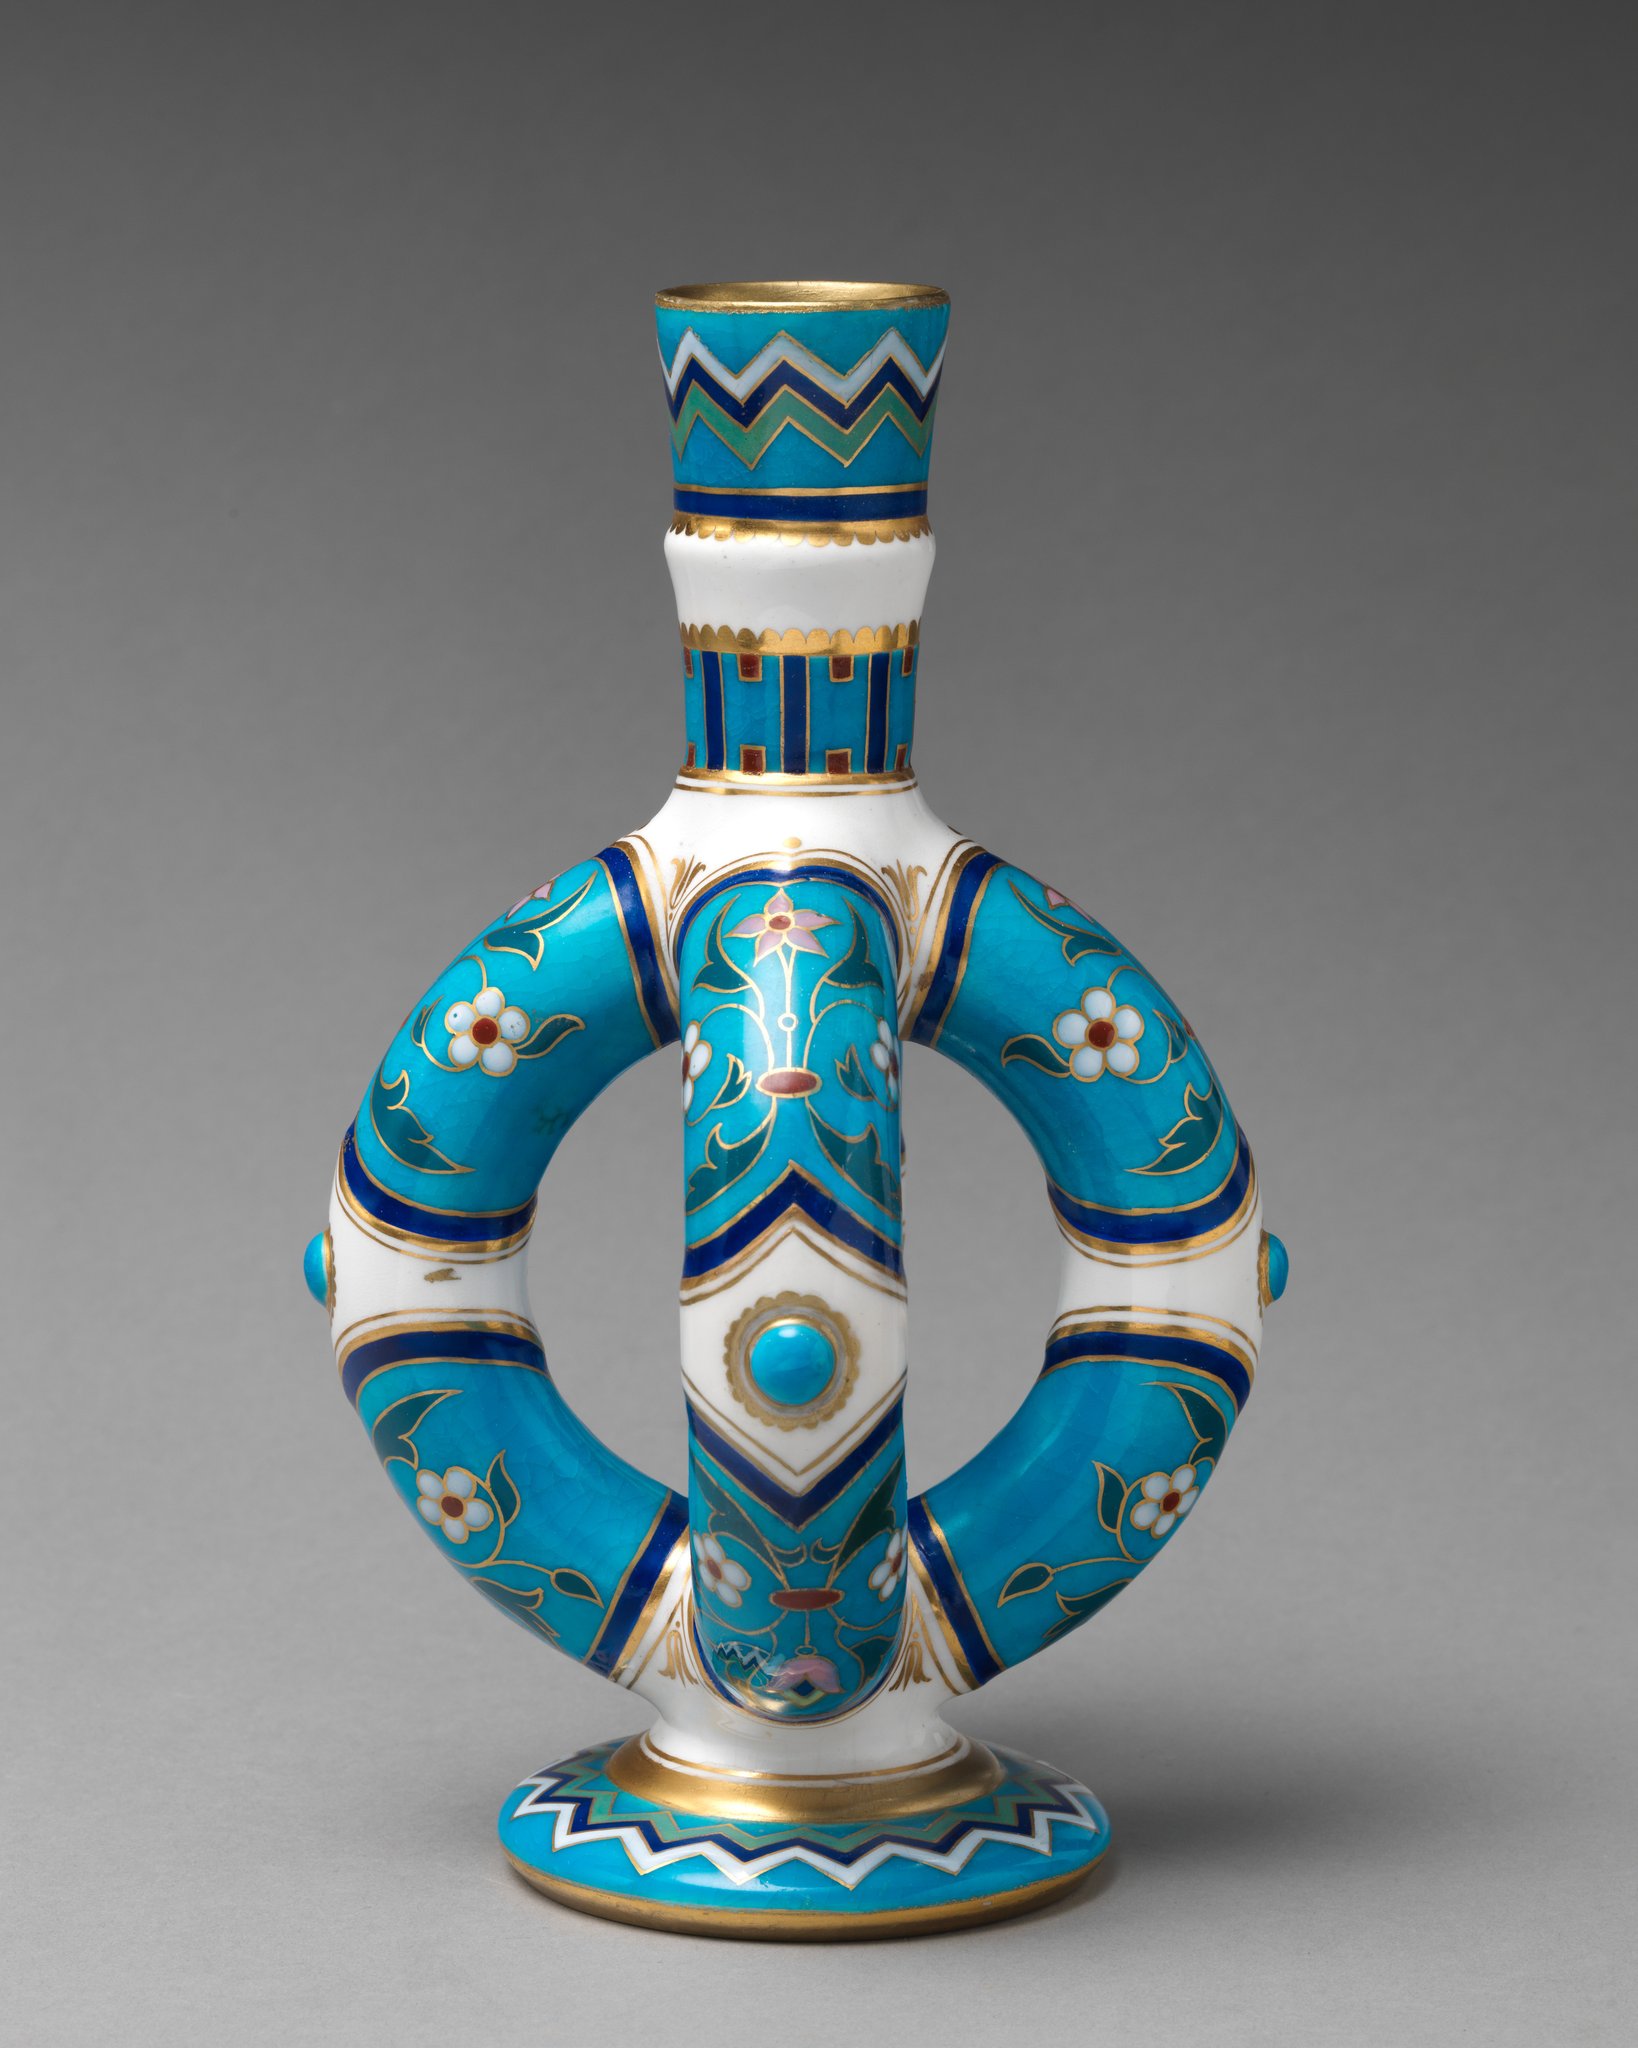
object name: vase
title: Candlestick (one of a pair)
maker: minton(s)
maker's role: maker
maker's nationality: british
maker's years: 1793-2001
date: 1872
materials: bone china, enamel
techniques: gilding